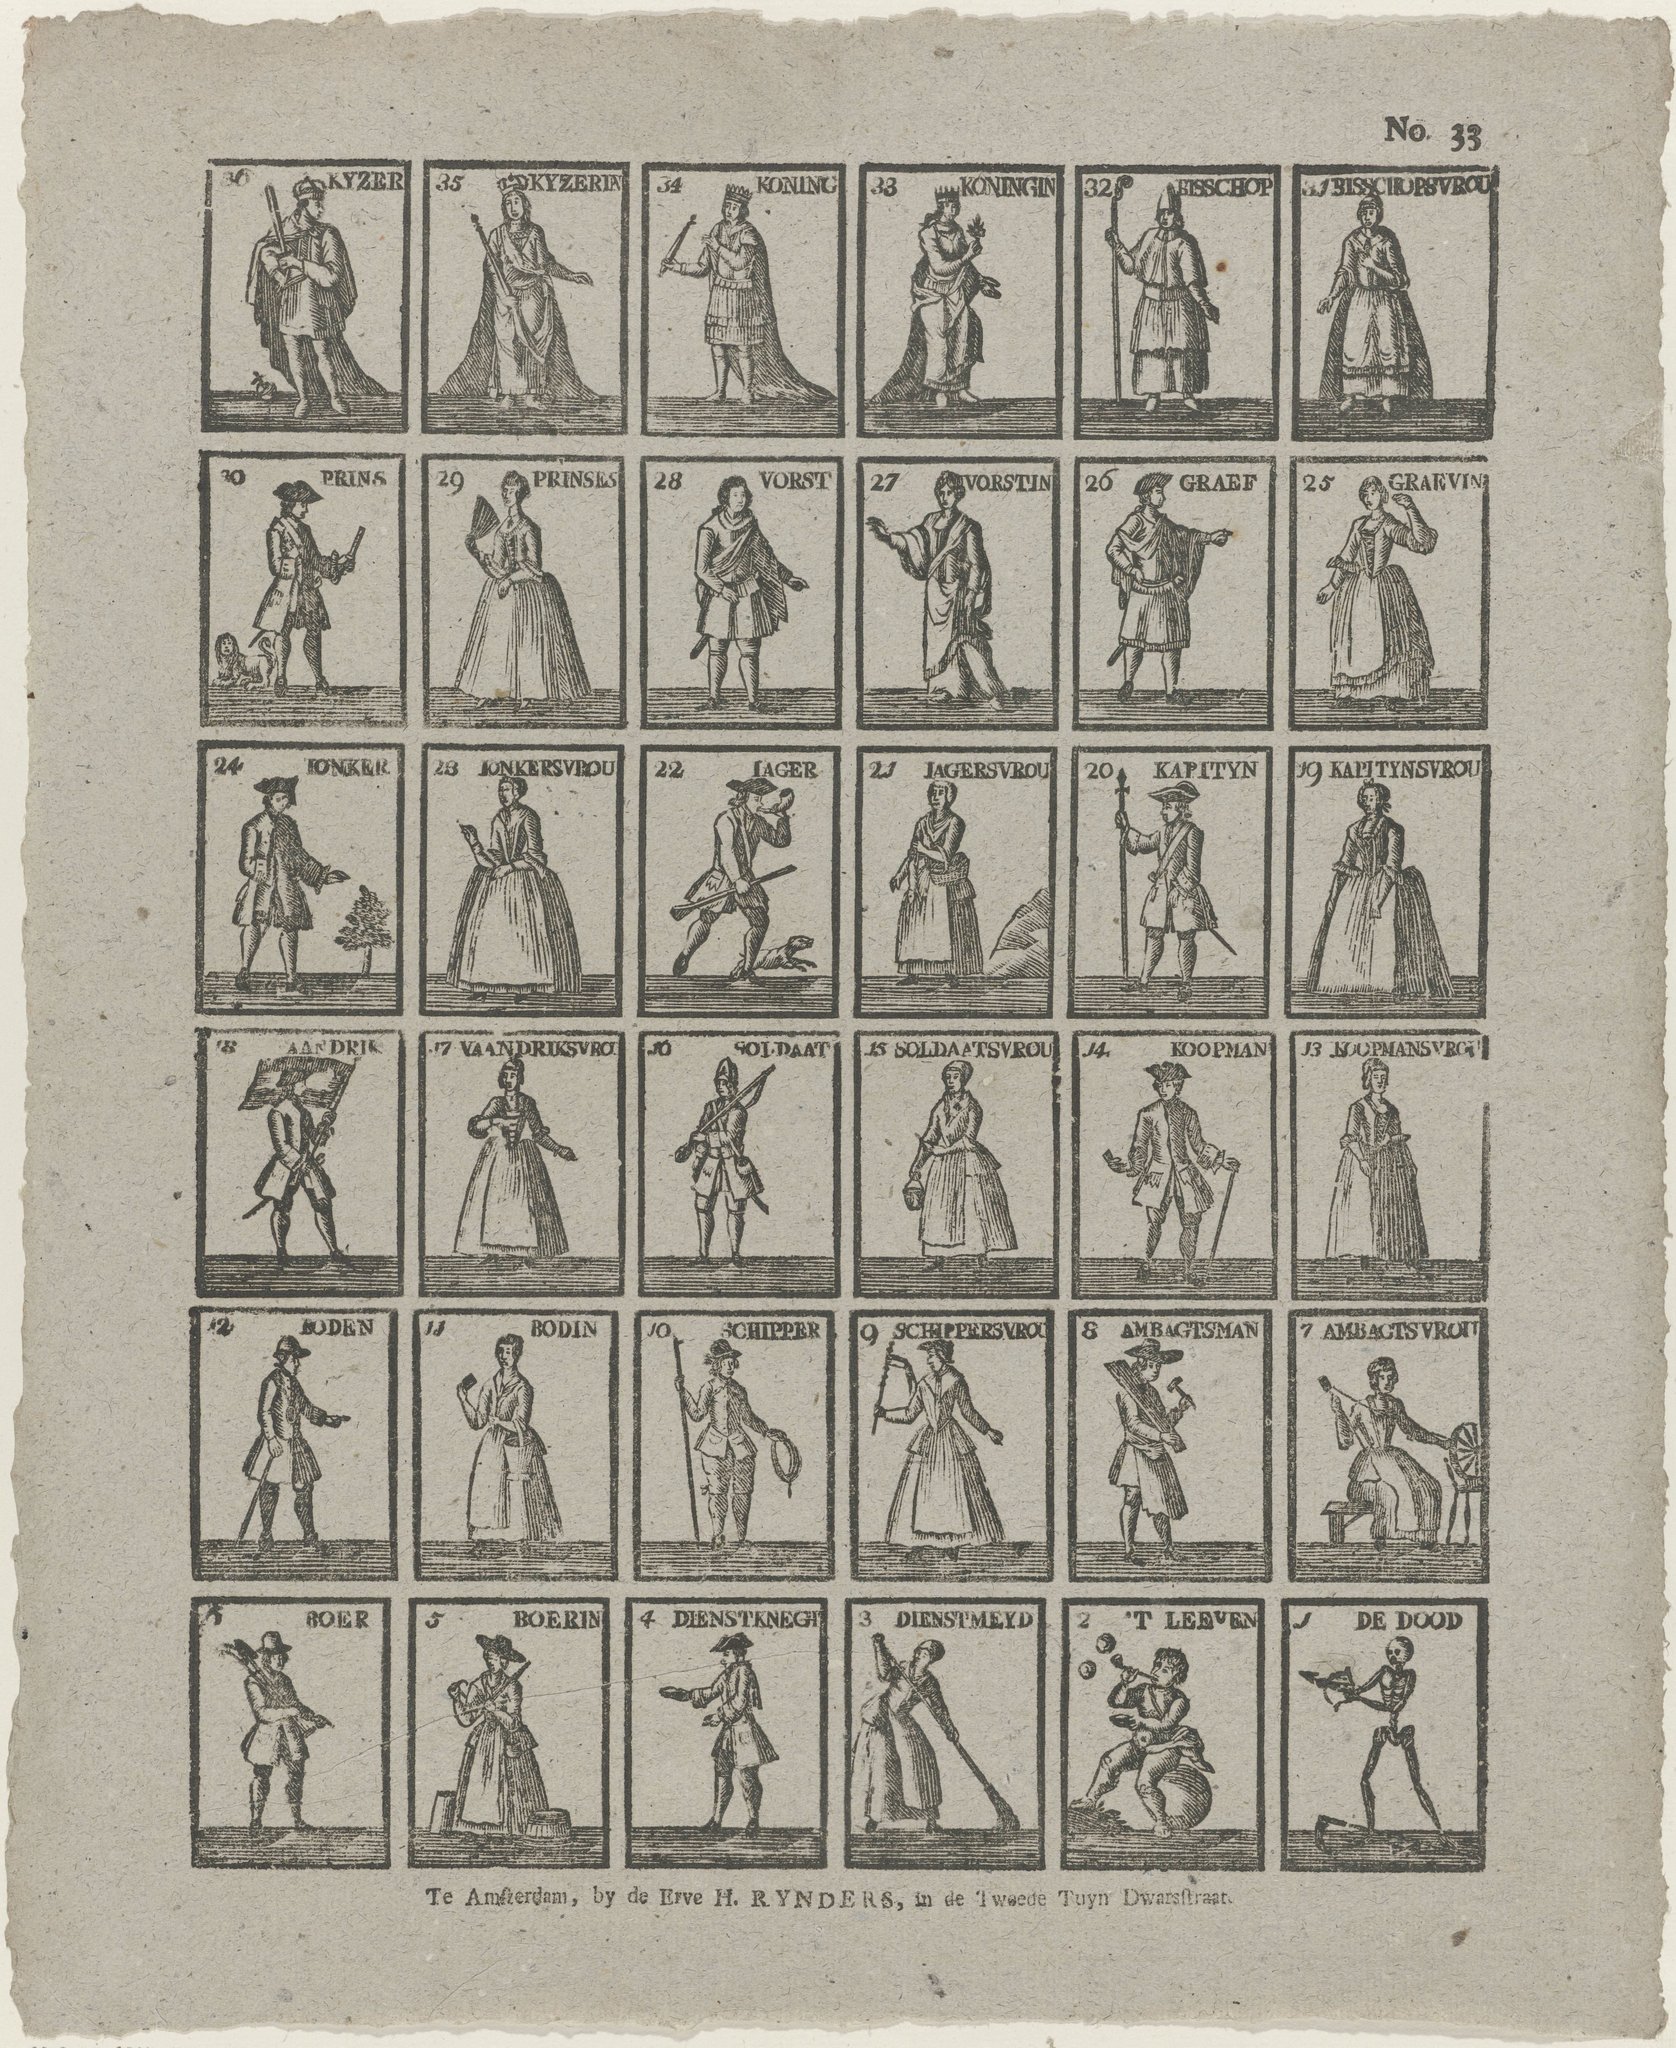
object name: card game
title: Floskaartjes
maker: Anonymous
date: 1831-1854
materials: paper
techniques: letterpress printing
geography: amsterdam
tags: symbols and personifications of death, social position, playing-cards, nobility and patriciate; chivalry, knighthood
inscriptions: collector's mark: Lugt 2760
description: Blad met 36 speelkaarten (floskaartjes) met voorstellingen van verschillende figuren. De afbeeldingen vormen achttien paren, aflopend genummerd van bovenaan links nummer 36 tot onderaan rechts nummer 1. Op de twee laagste nummers na tonen ze zeventien koppels, man en vrouw, met de man net één nummer hoger dan de vrouw, waarbij elk paar een beroep of een maatschappelijke positie voorstelt. Genummerd rechtsboven: No. 33.